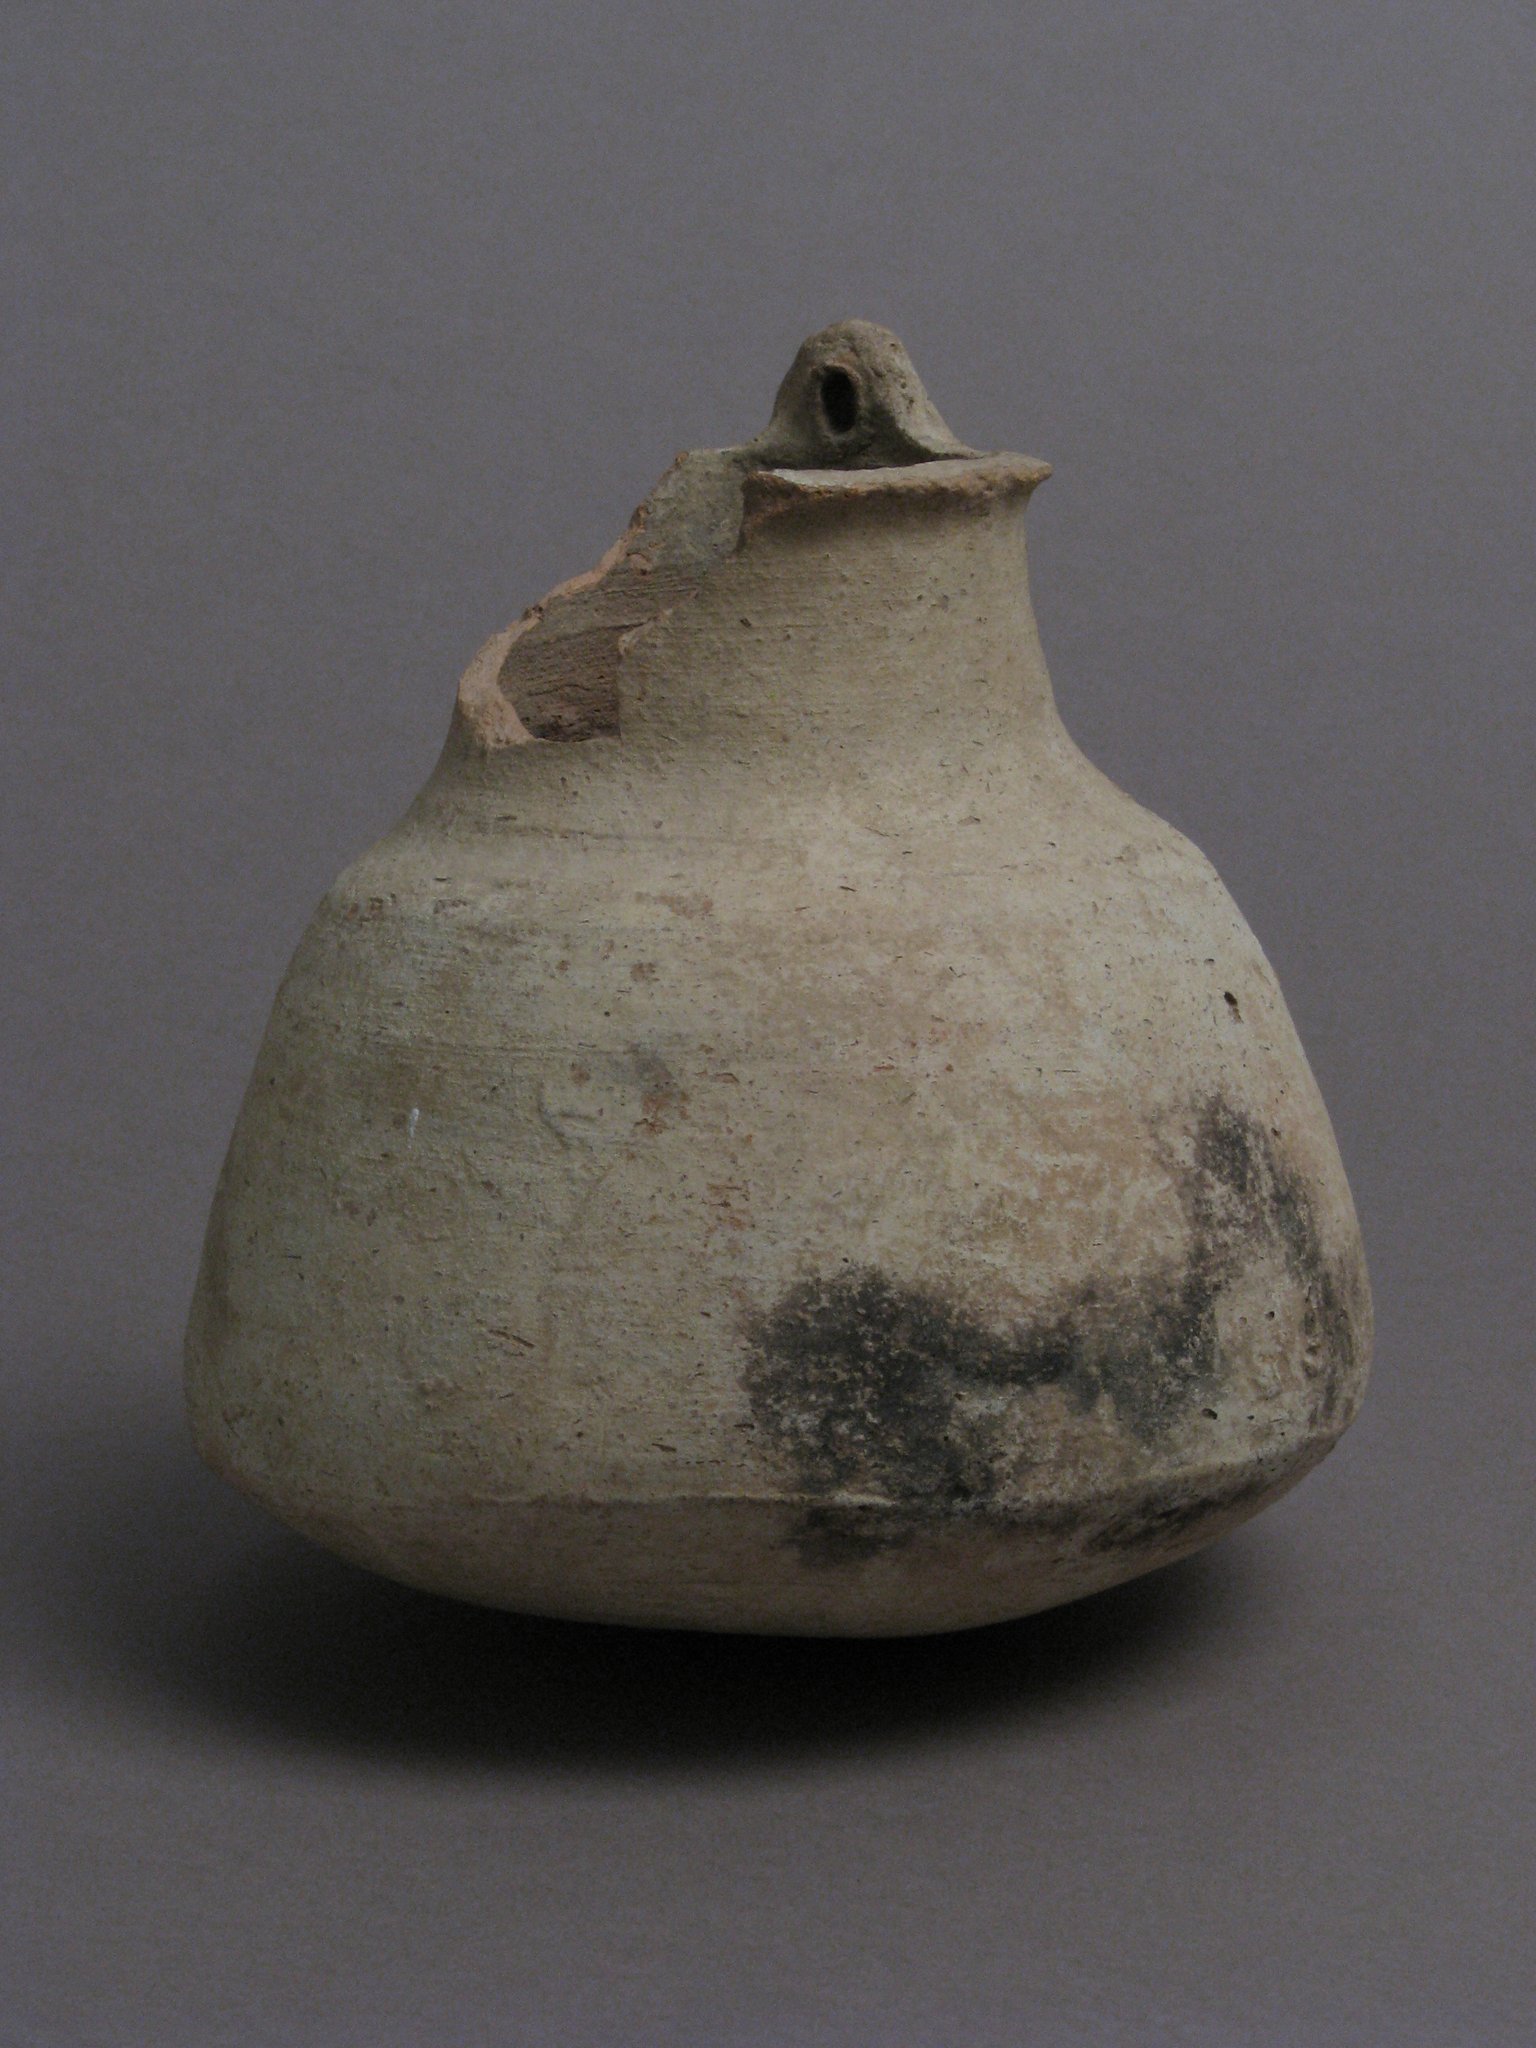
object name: vessel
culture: coptic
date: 301-700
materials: earthenware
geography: egypt